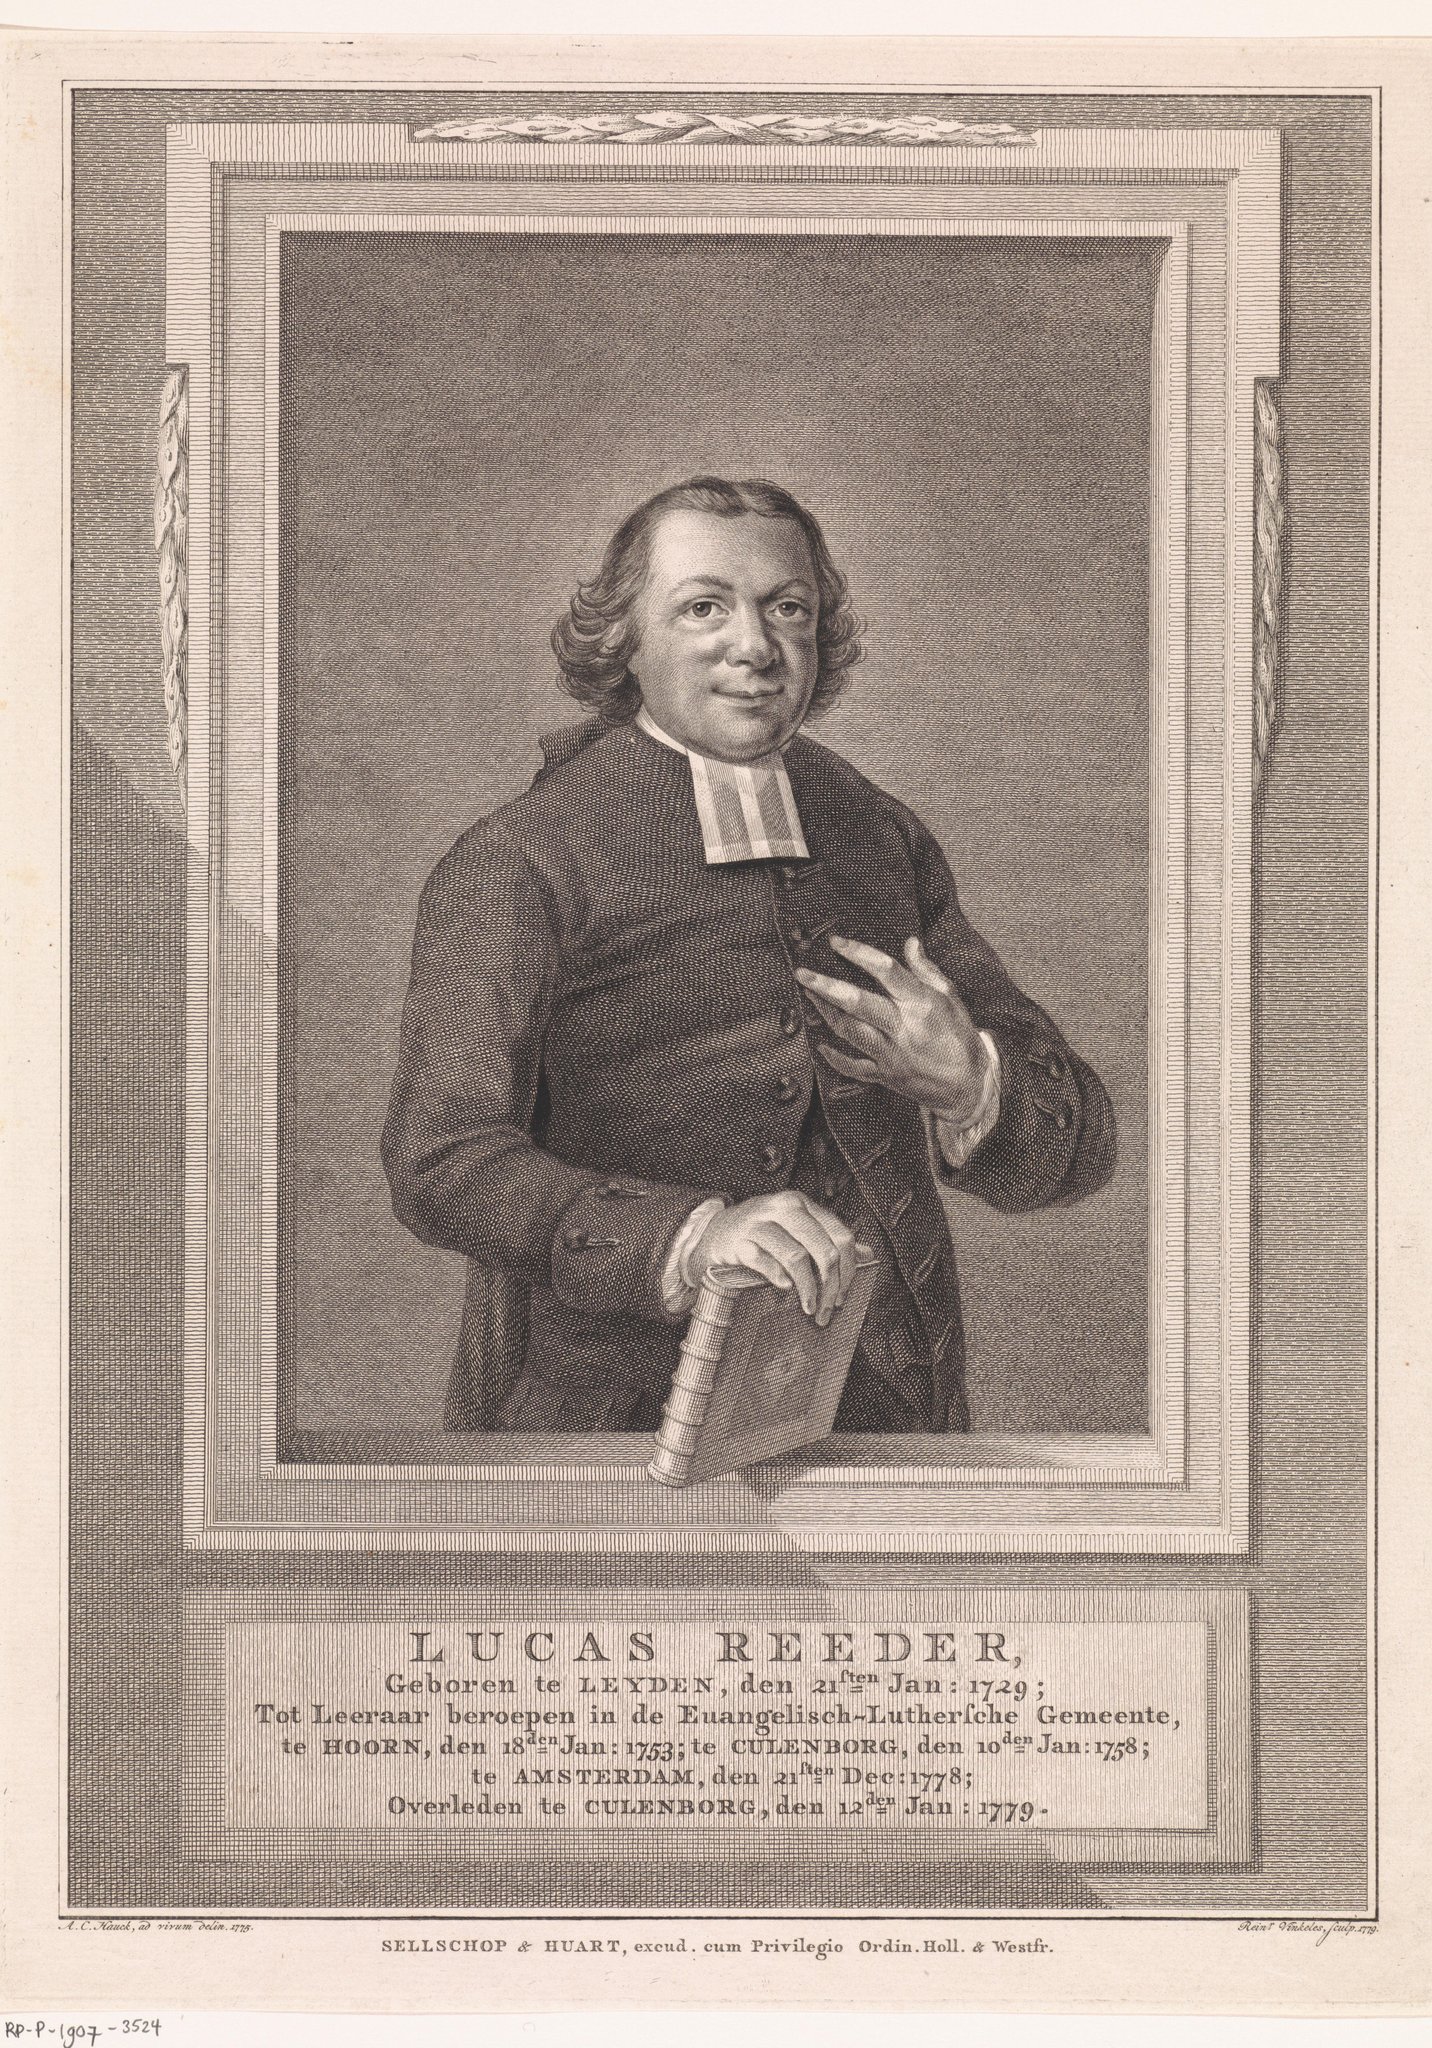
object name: print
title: Portret van Lucas Reeder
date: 1779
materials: paper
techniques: engraving, etching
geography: amsterdam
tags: book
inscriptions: collector's mark: Lugt 2228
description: Portret van de predikant Lucas Reeder in een architectonische omlijsting, zijn hand op een boek.